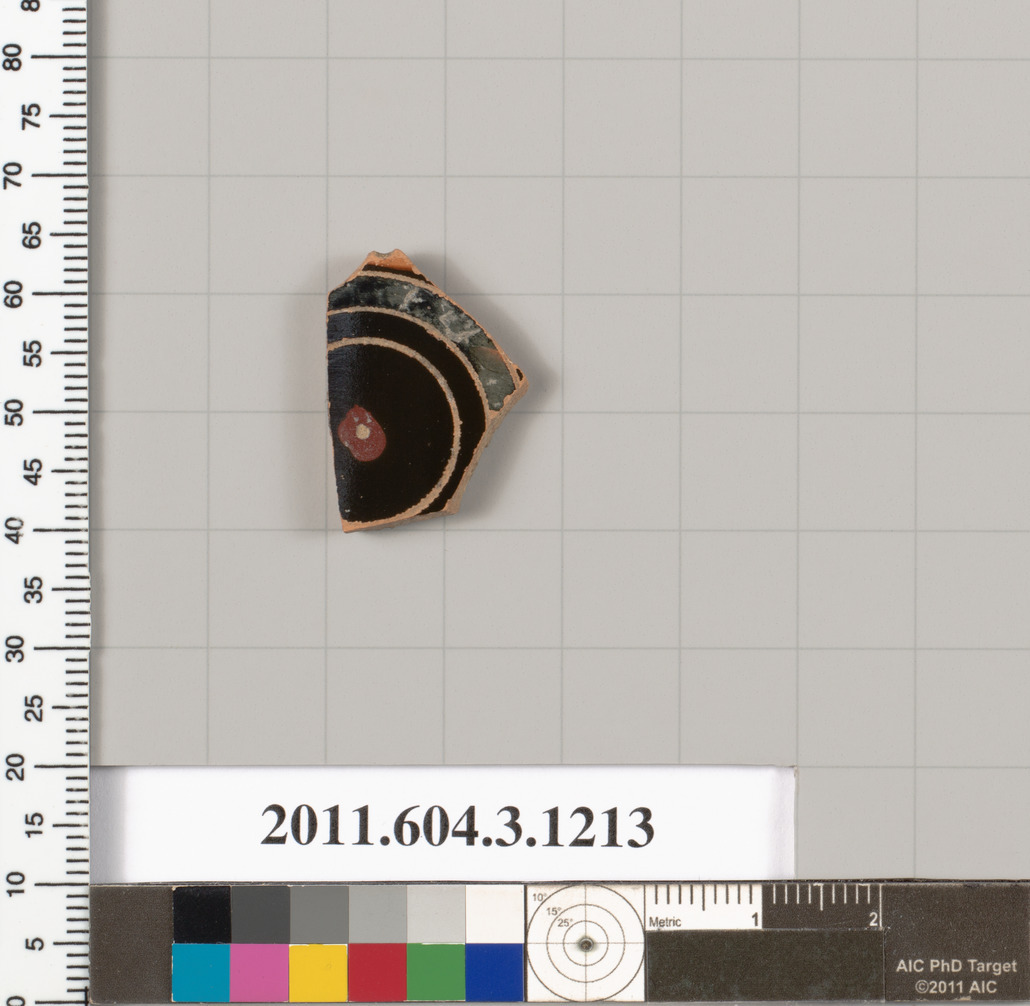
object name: mastoid or kyathos fragment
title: Terracotta fragment of a mastoid (drinking cup with narrow base) or a kyathos (cup-shaped ladle)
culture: greek, attic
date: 534-468 BCE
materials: terracotta